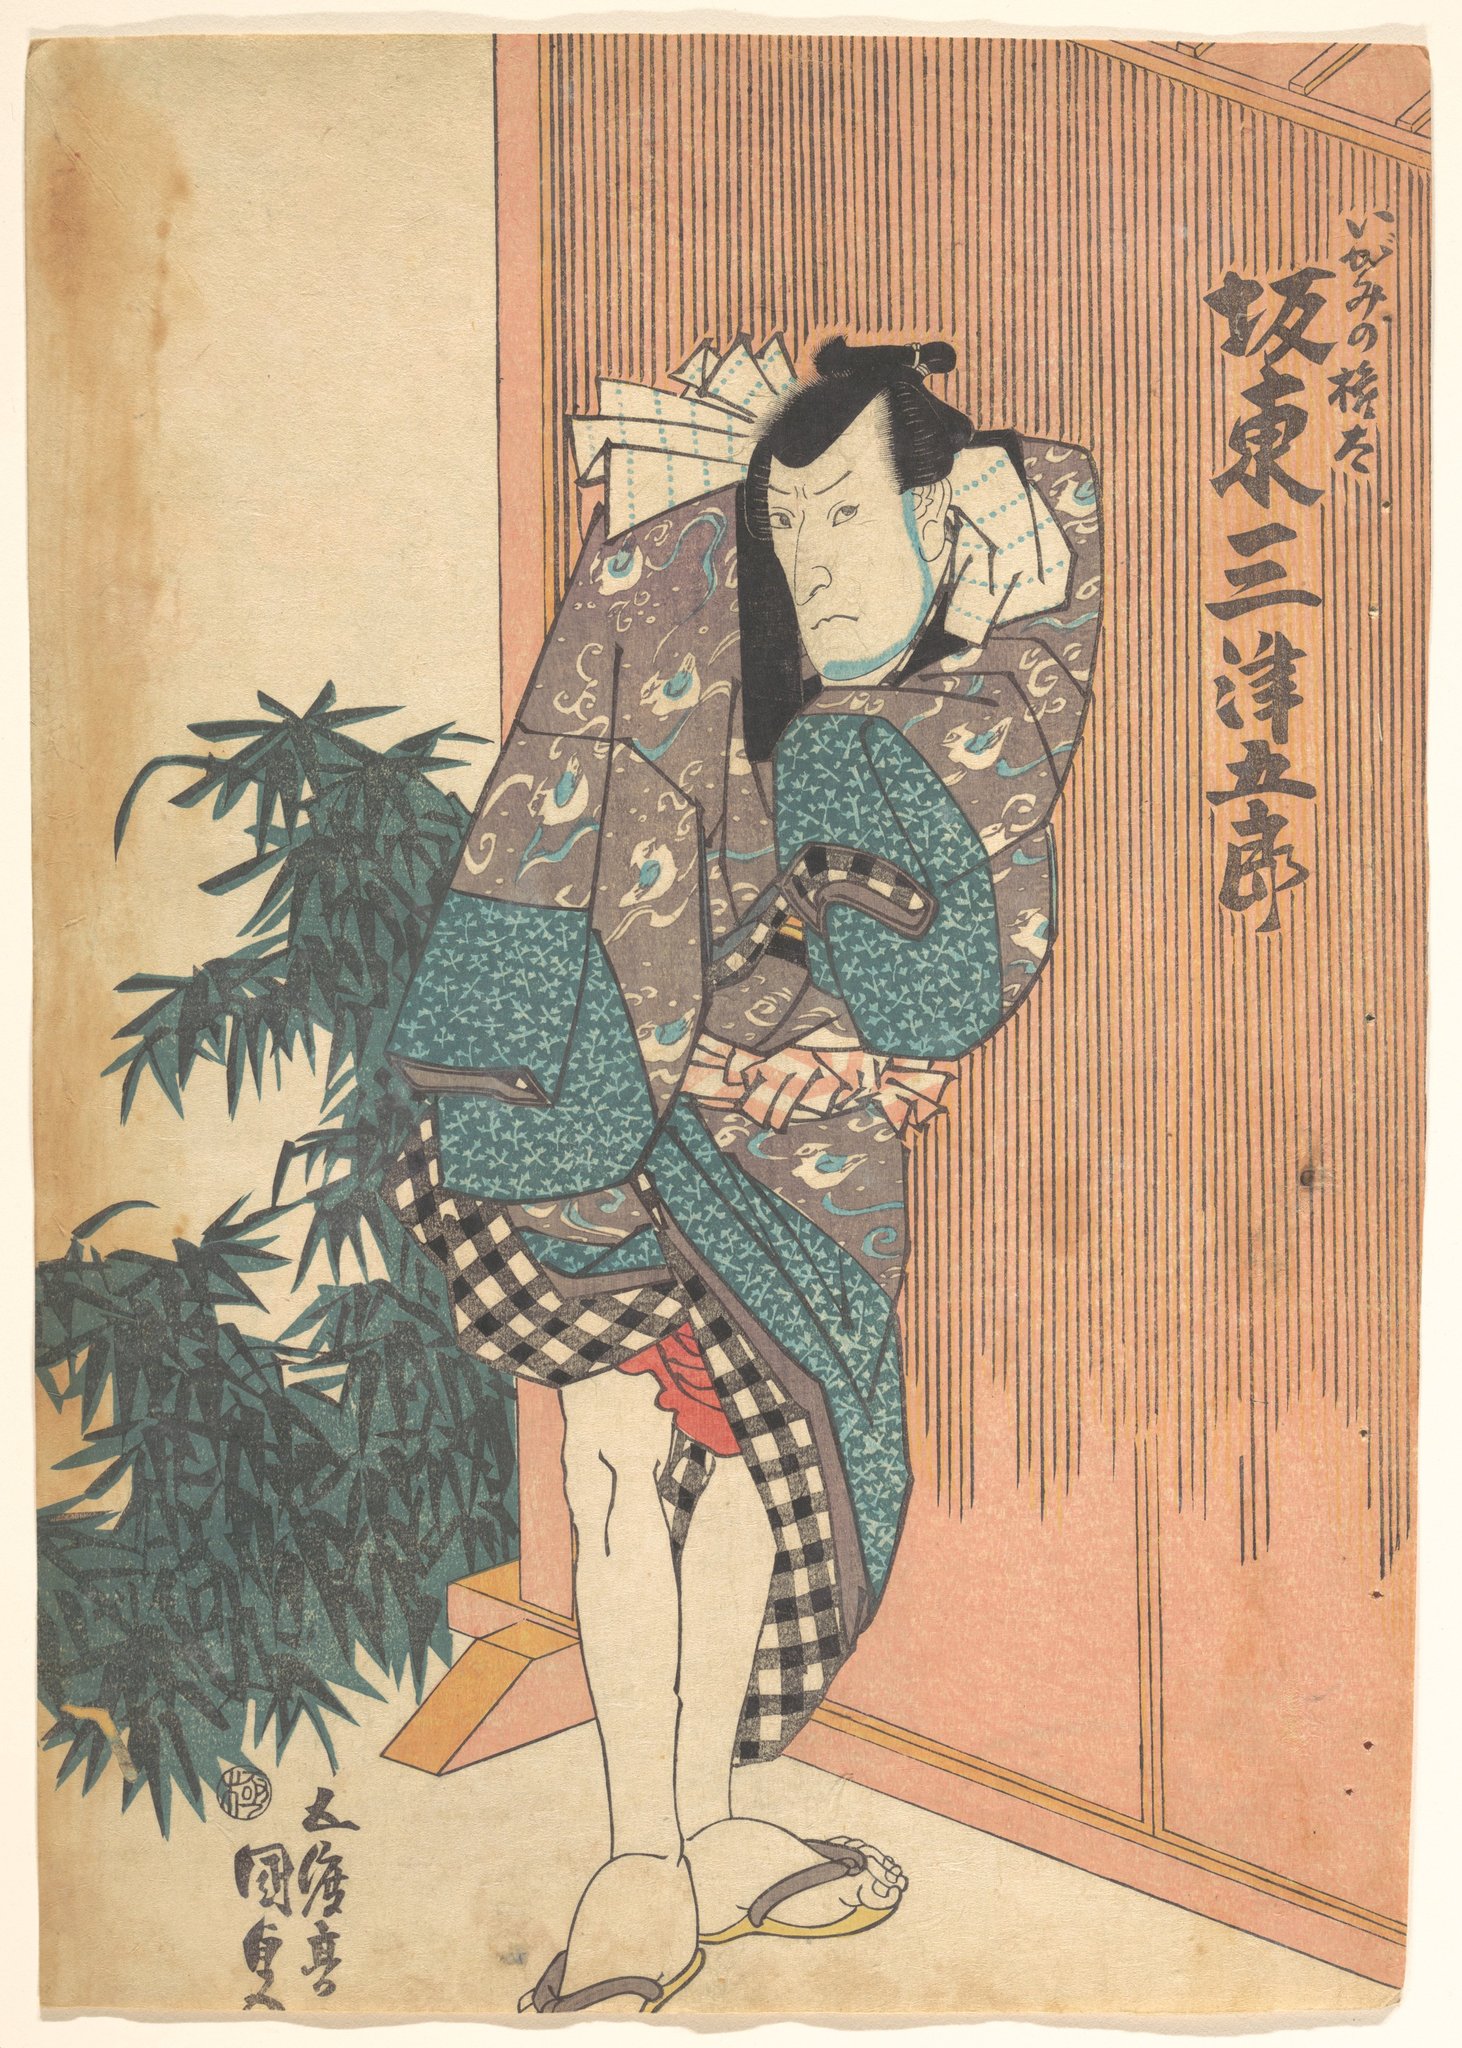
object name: print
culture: japanese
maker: utagawa kunisada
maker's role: artist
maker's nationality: japanese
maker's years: 1786-1864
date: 1801-1900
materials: ink, paper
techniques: woodblock print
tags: men